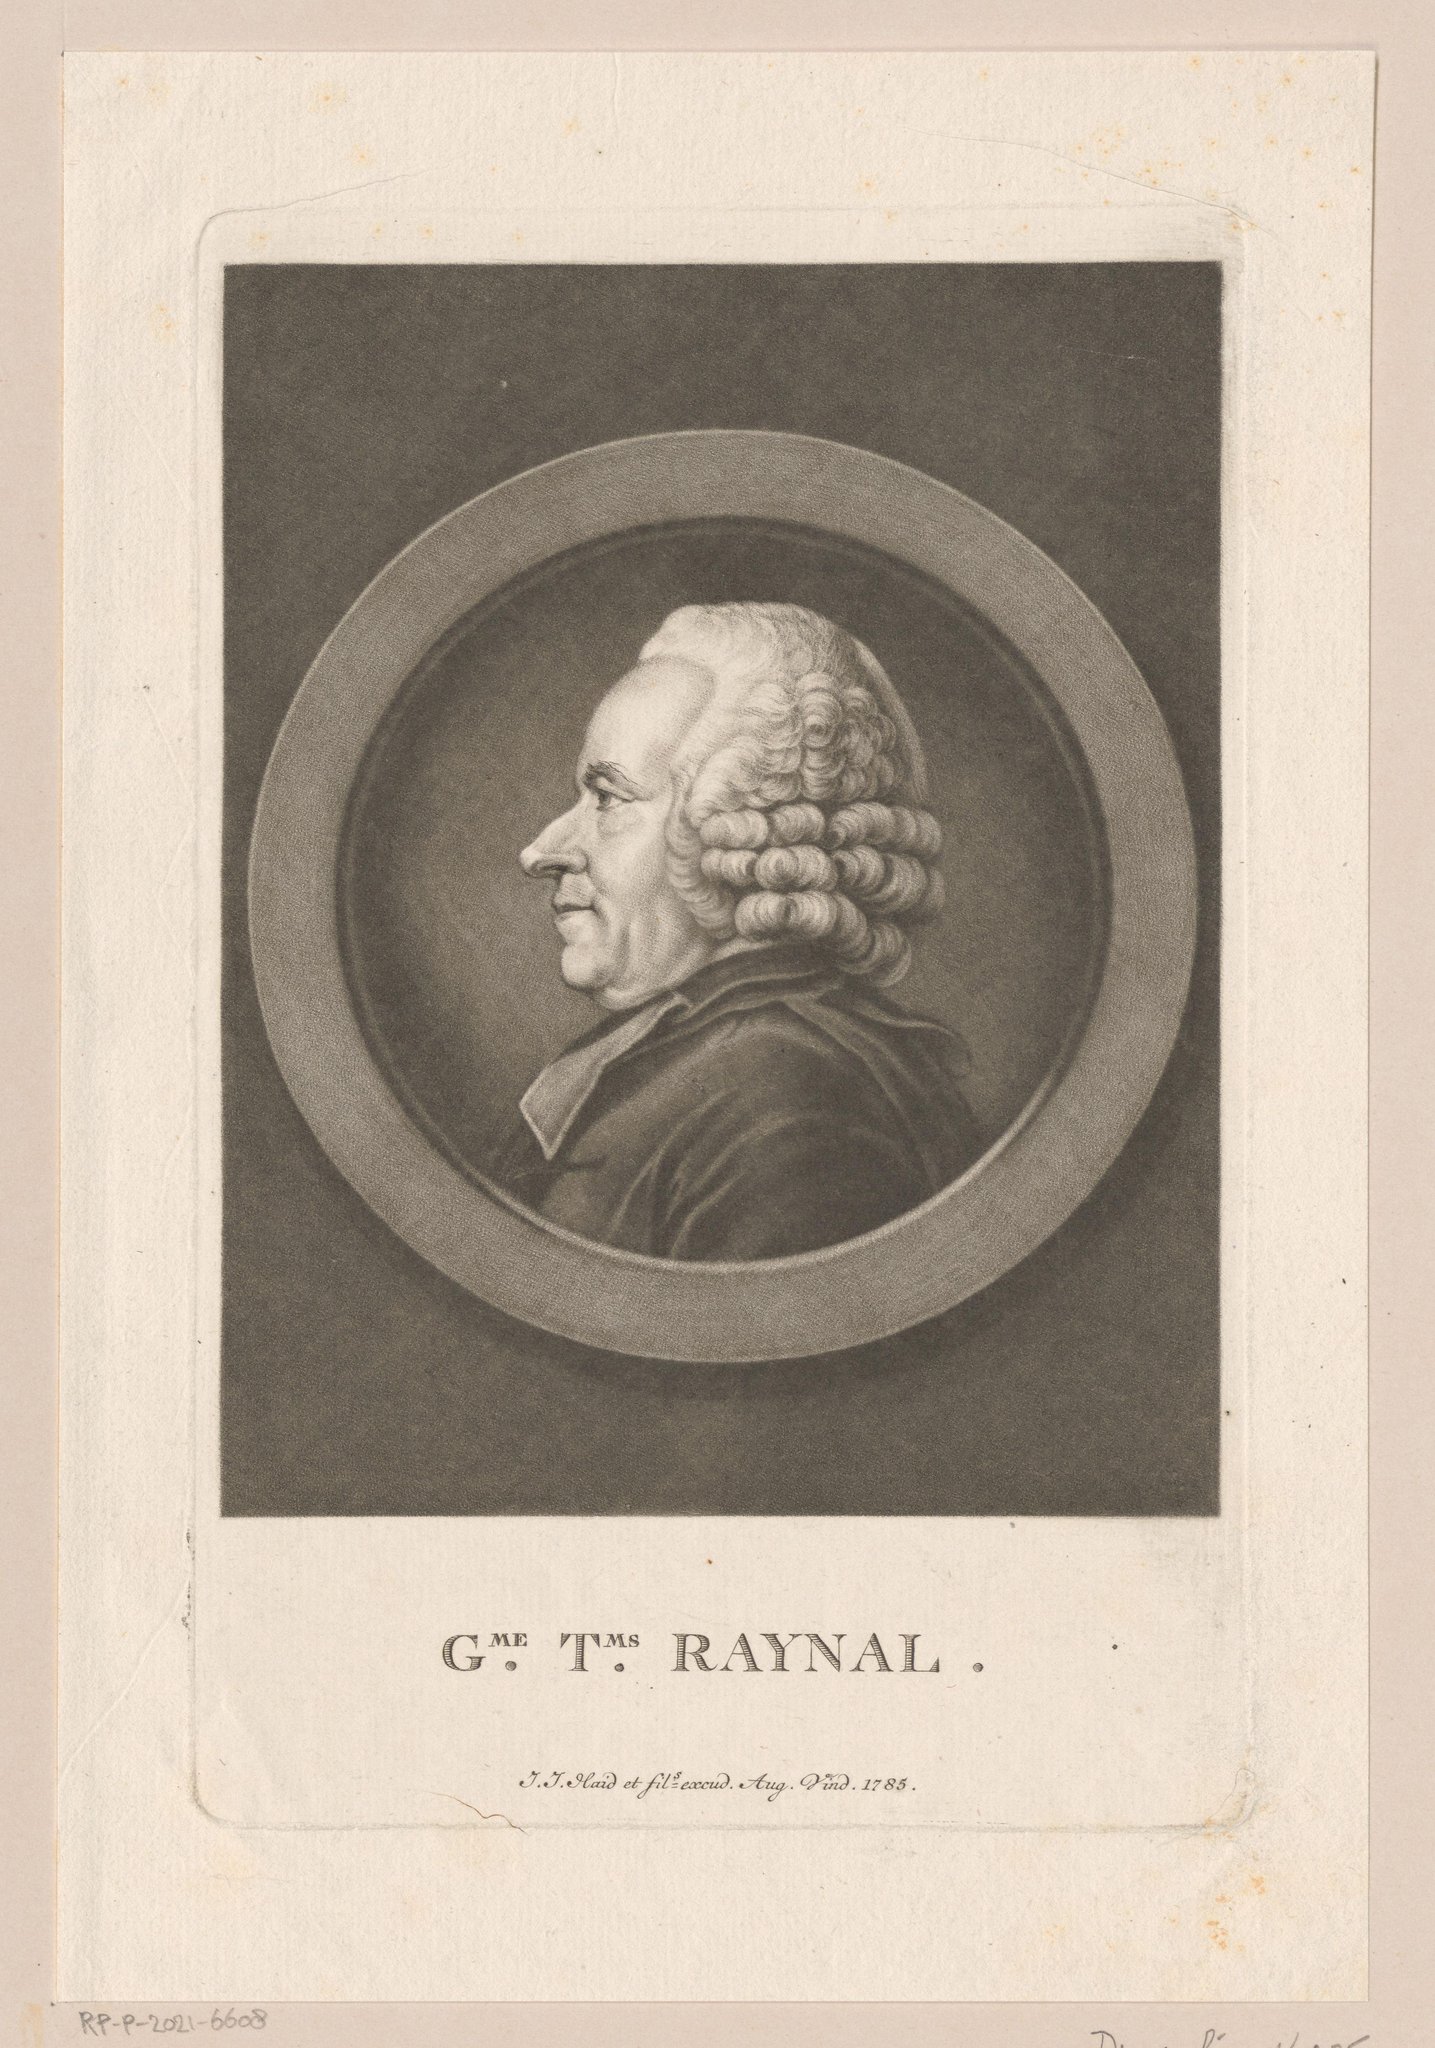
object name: print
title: Portret van Guillaume-Thomas François Raynal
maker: Anonymous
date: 1785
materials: paper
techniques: engraving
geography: augsburg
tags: historical persons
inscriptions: date